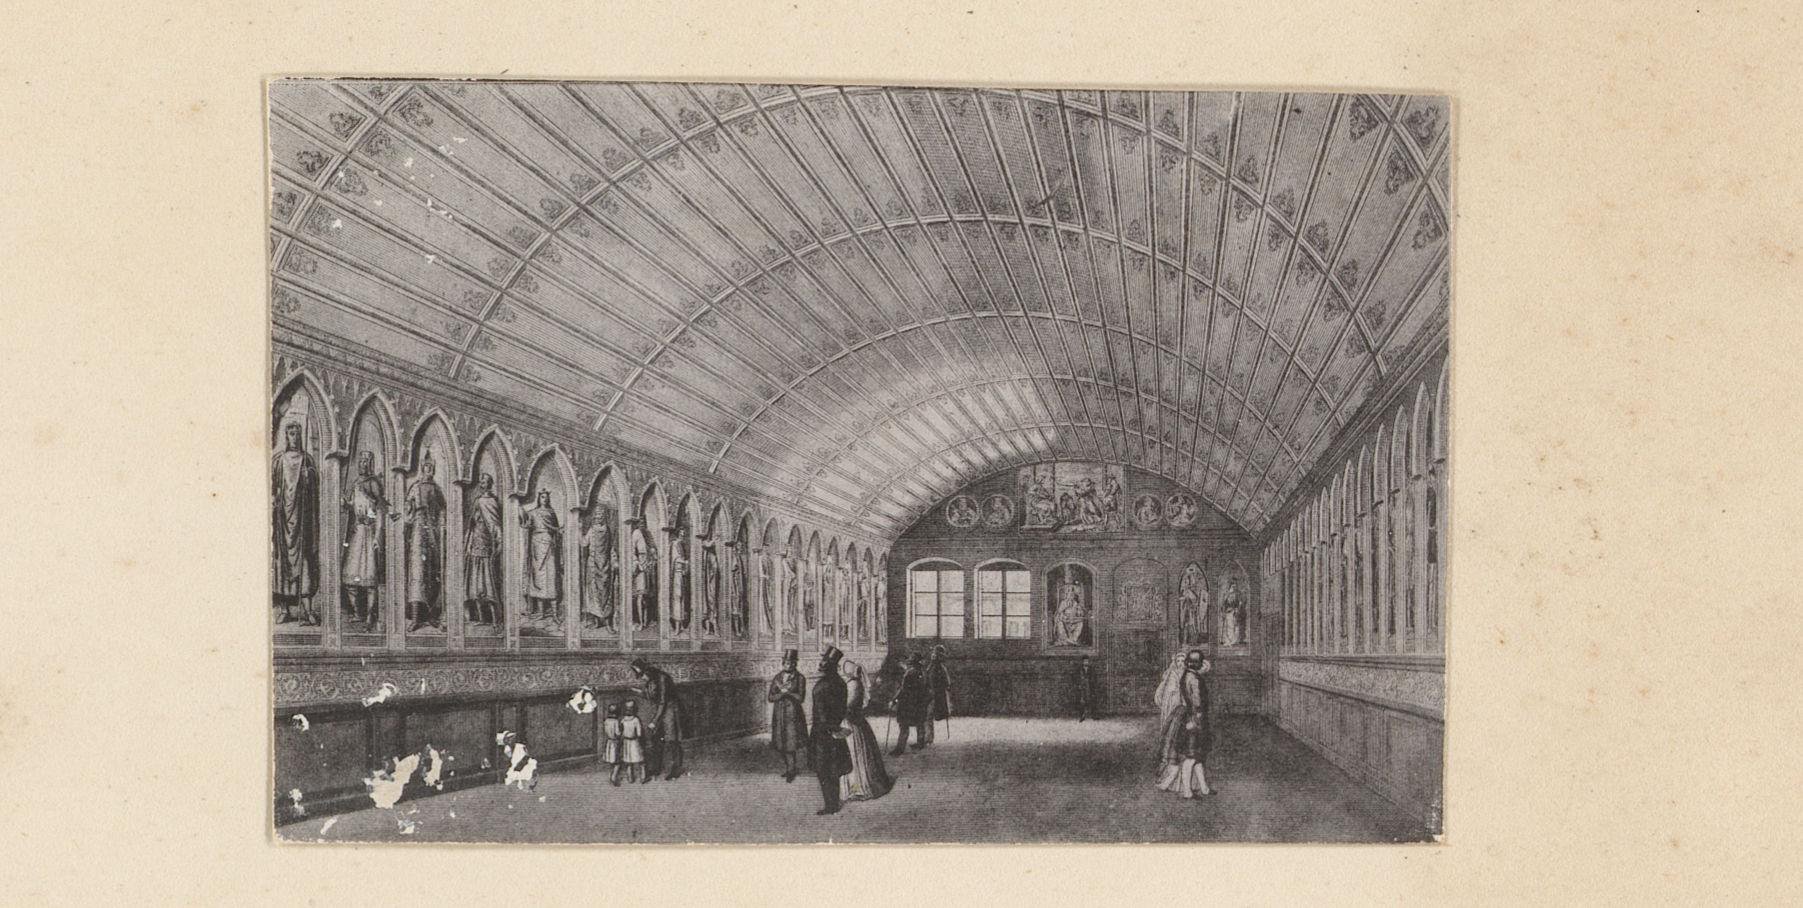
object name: reproduction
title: Reproductie van een staalgravure van een tentoonstelling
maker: Anonymous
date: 1870-1890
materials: paper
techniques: photograph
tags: permanent exhibition, museum, europe